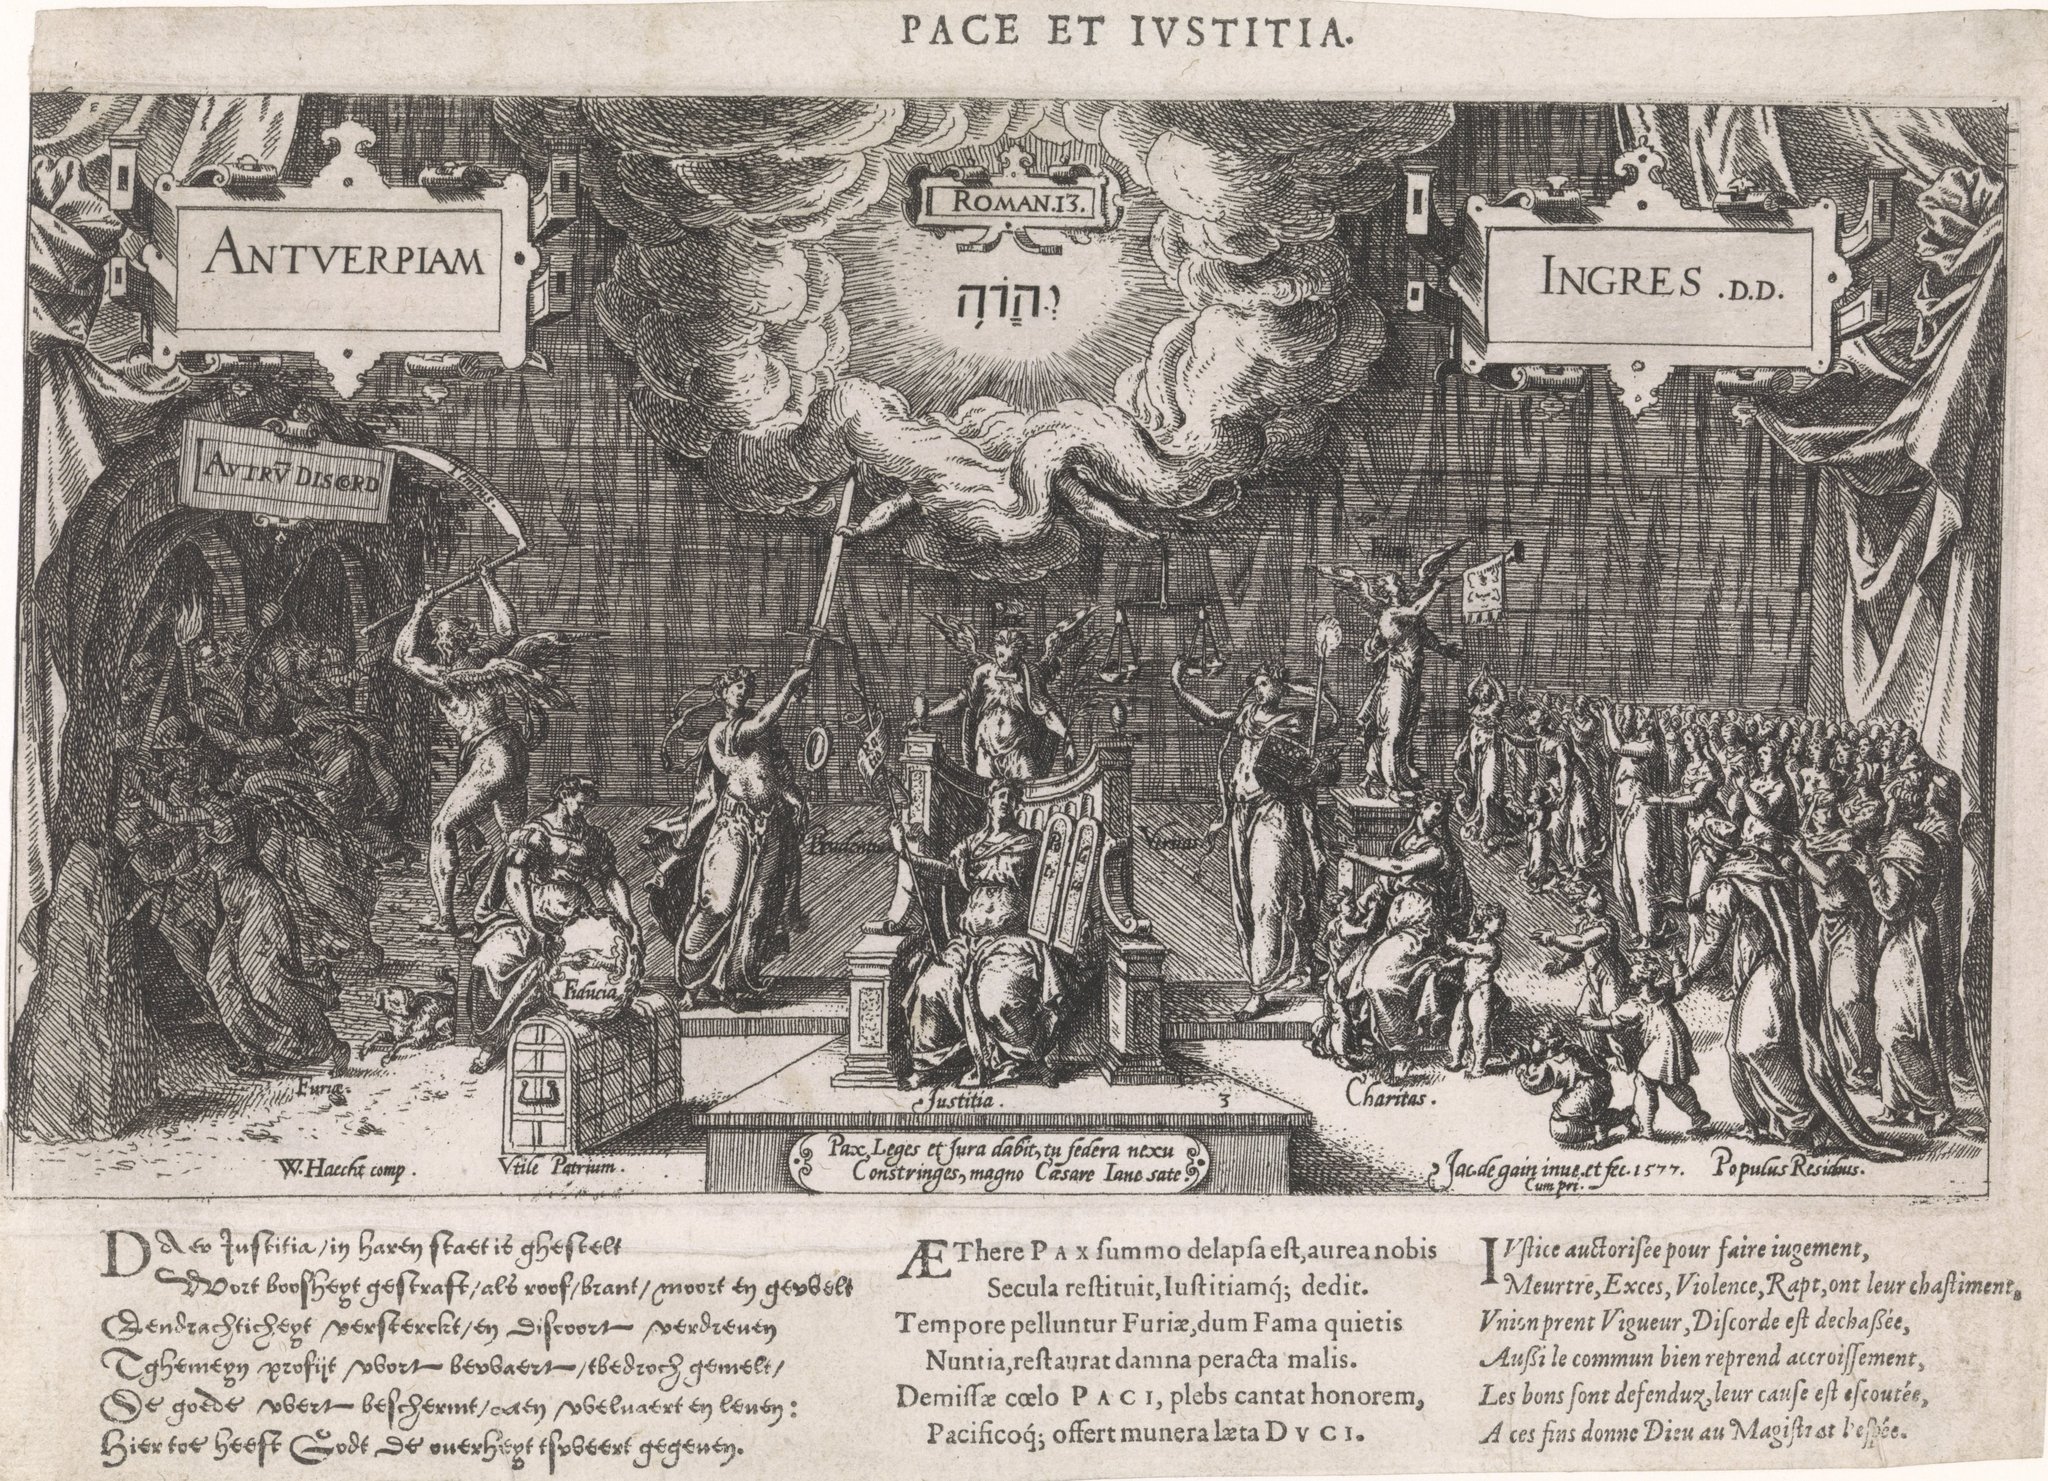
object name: print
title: Vrede en Gerechtigheid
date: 1577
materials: paper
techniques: etching, letterpress printing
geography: antwerp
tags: don juan van oostenrijk, charity, 'caritas'; 'carità' (ripa) ~ one of the three theological virtues, justice, 'justitia'; 'giustitia divina' (ripa) ~ one of the four cardinal virtues, prudence, 'prudentia'; 'prudenza' (ripa) ~ one of the four cardinal virtues, symbols, allegories of peace, 'pax'; 'pace' (ripa), fidelity; 'fedeltà' (ripa), truth; 'verità' (ripa), the arts of the stage: ballet, theatre, musical drama, motion picture, antwerp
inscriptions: collector's mark: Lugt 2760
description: Toneel waarin de heerschappij van Rechtvaardigheid (Justitia) is hersteld. Justitia zit op haar troon met aan weerszijden Trouw (Fiducia), Voorzichtigheid (Prudentia), Vrede (Pax), Waarheid (Veritas) en Liefde (Caritas). Links drijft Tijd de ondeugden terug in de duistere grot van de Tweedracht. Allegorische verbeelding van de strijd tussen goed en kwaad, gadegeslagen door de bevolking van Antwerpen. In de wolken het tetragram. In de voorstelling cartouches met opschriften in het Latijn. Onder de voorstelling gedrukt drie verzen van elk 6 regels in het Nederlands, Latijn en Frans.